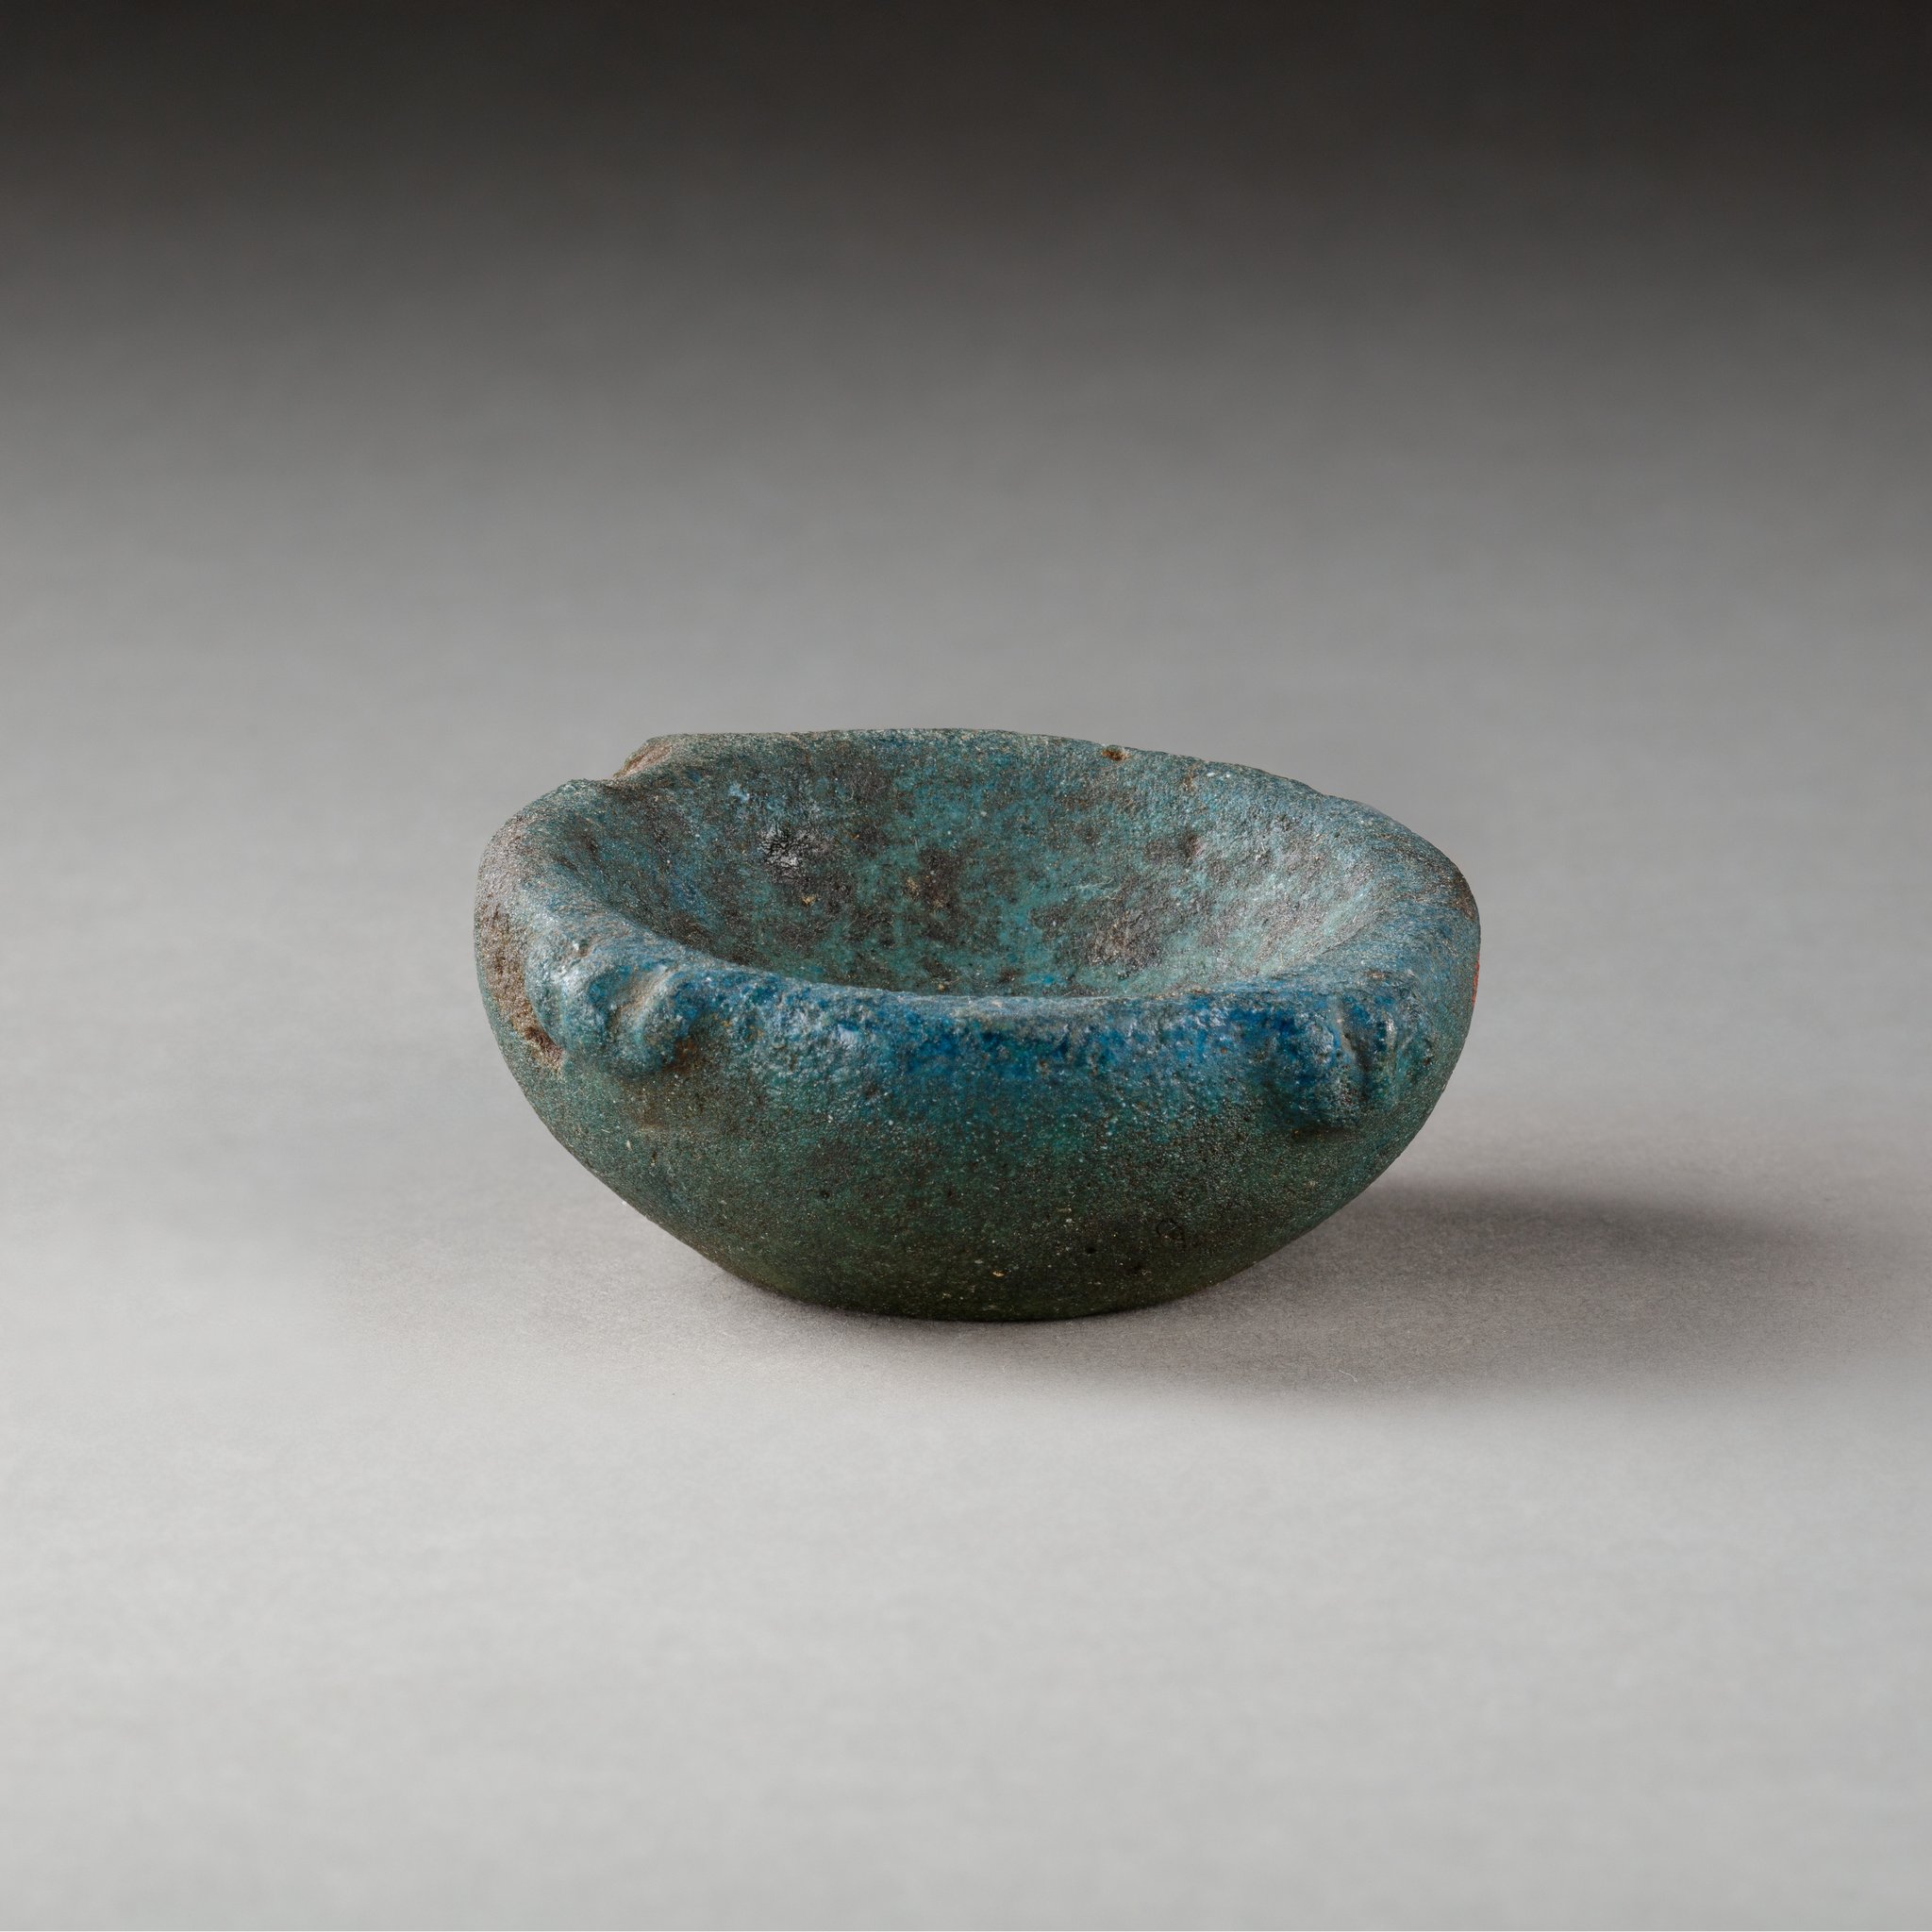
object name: dish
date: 1580-1479 BCE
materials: faience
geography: egypt